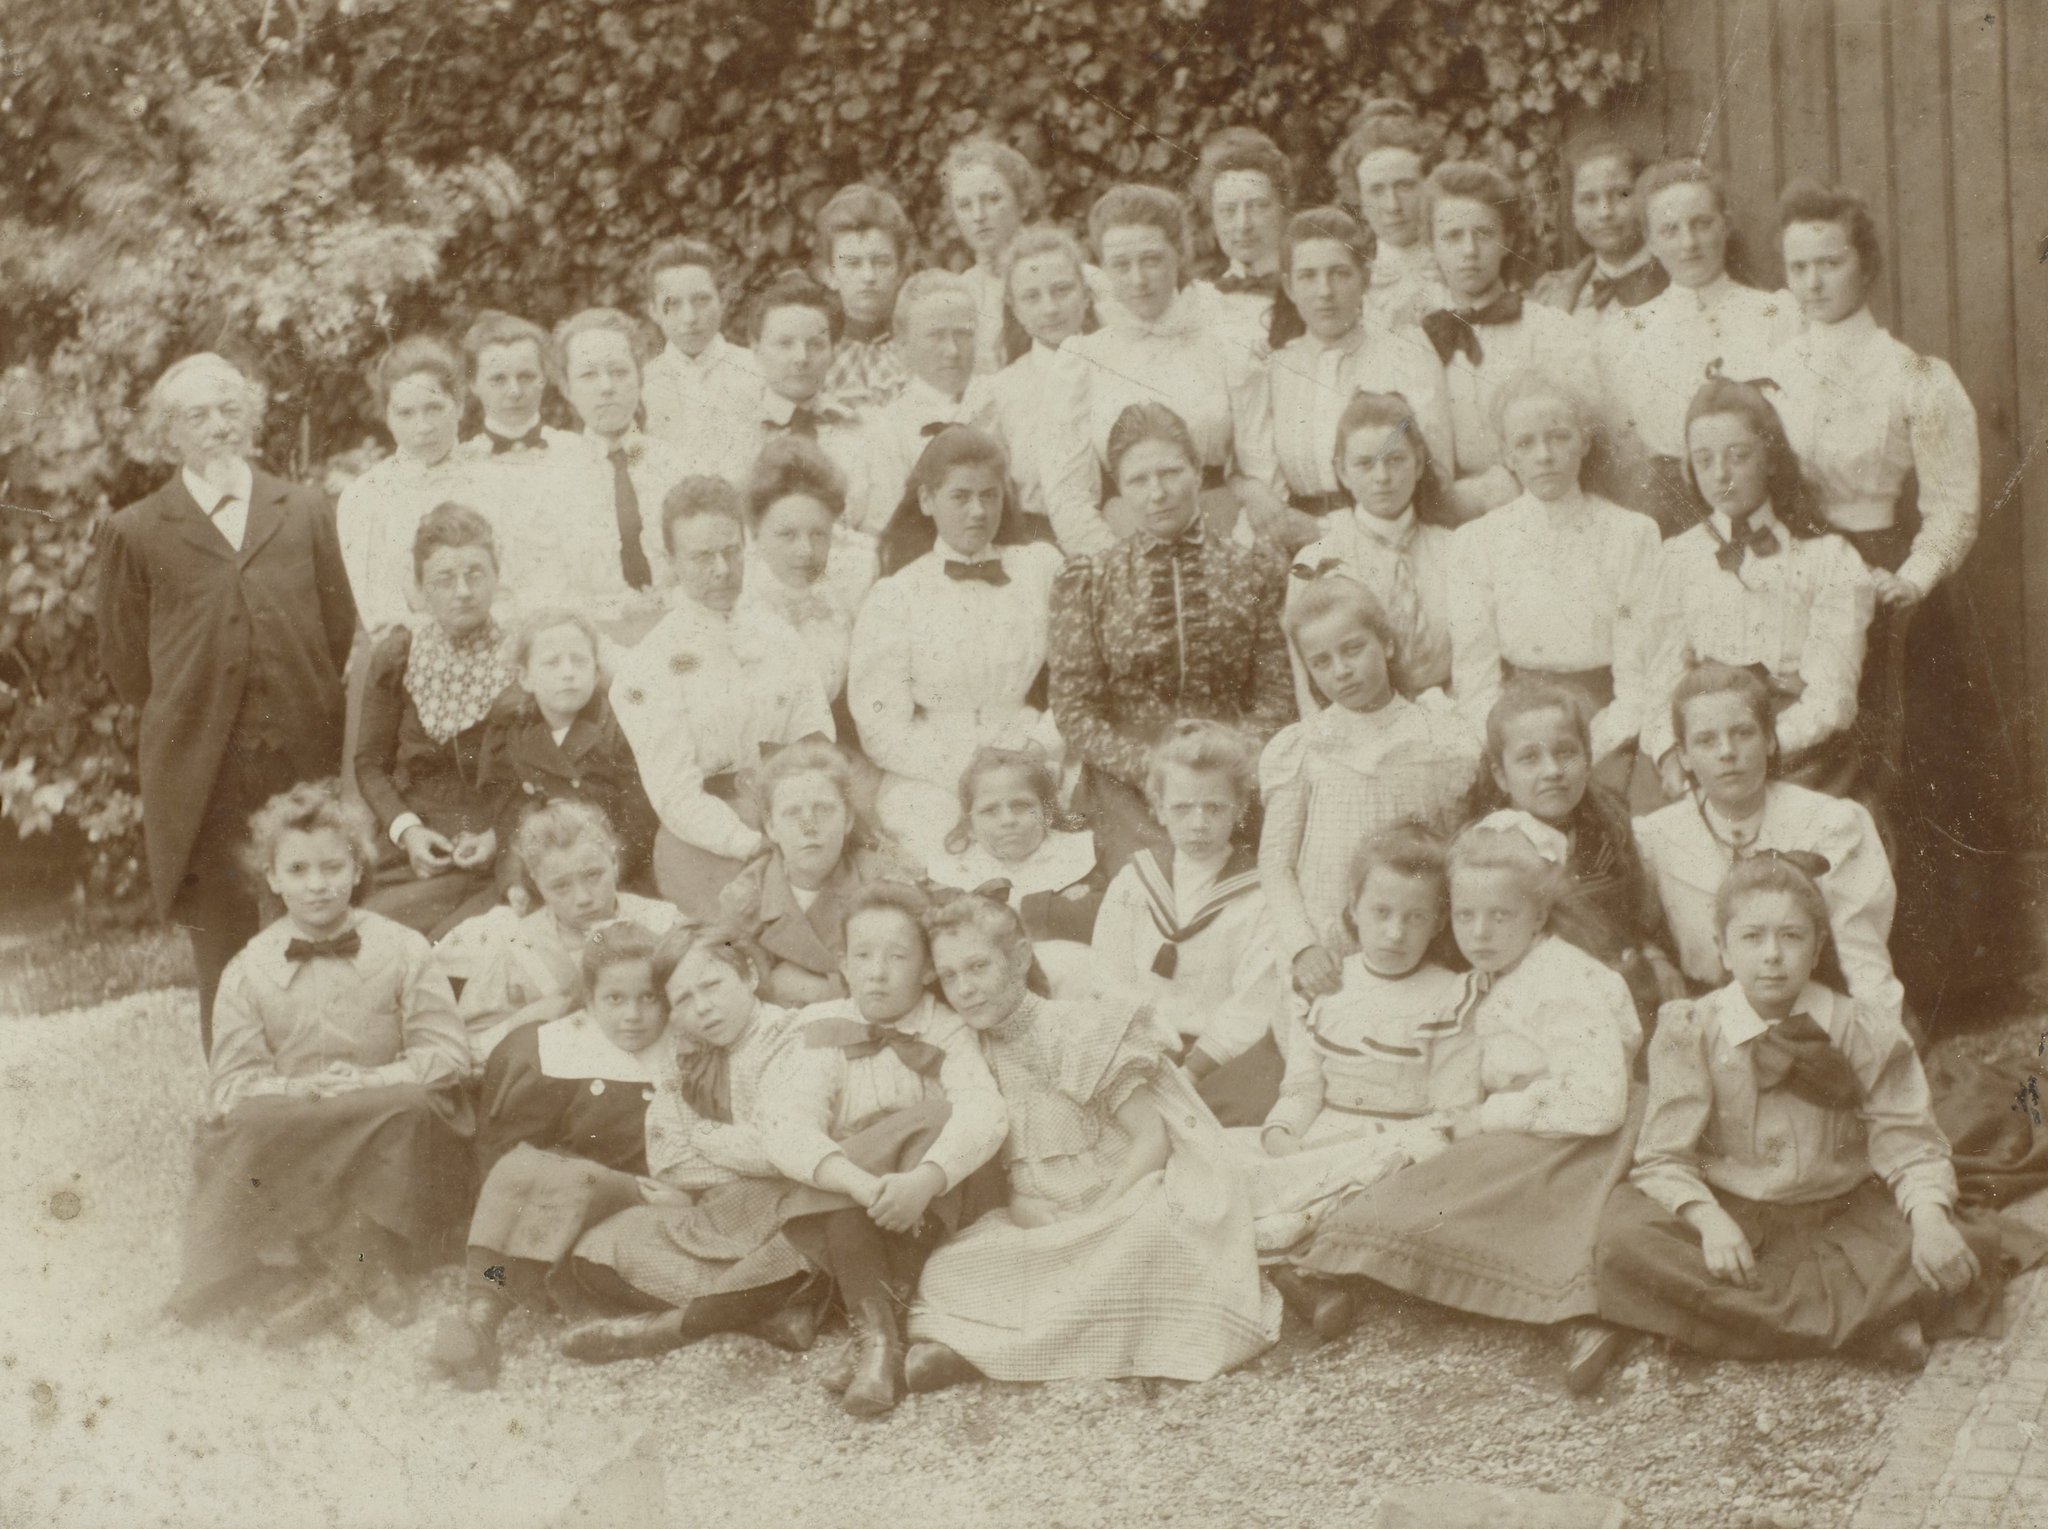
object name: photograph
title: Schoolfoto op meisjesschool, rechtsvoor Charlotte A Matthes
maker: jan willem arnold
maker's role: fotograaf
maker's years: 1842-1909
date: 1880-1900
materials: paper, photographic support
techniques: albumen print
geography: the hague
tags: going to school (+ portrait of teacher, professor), amsterdam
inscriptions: name: ‘Onderaan rechts voor Charlotte A Matthes’